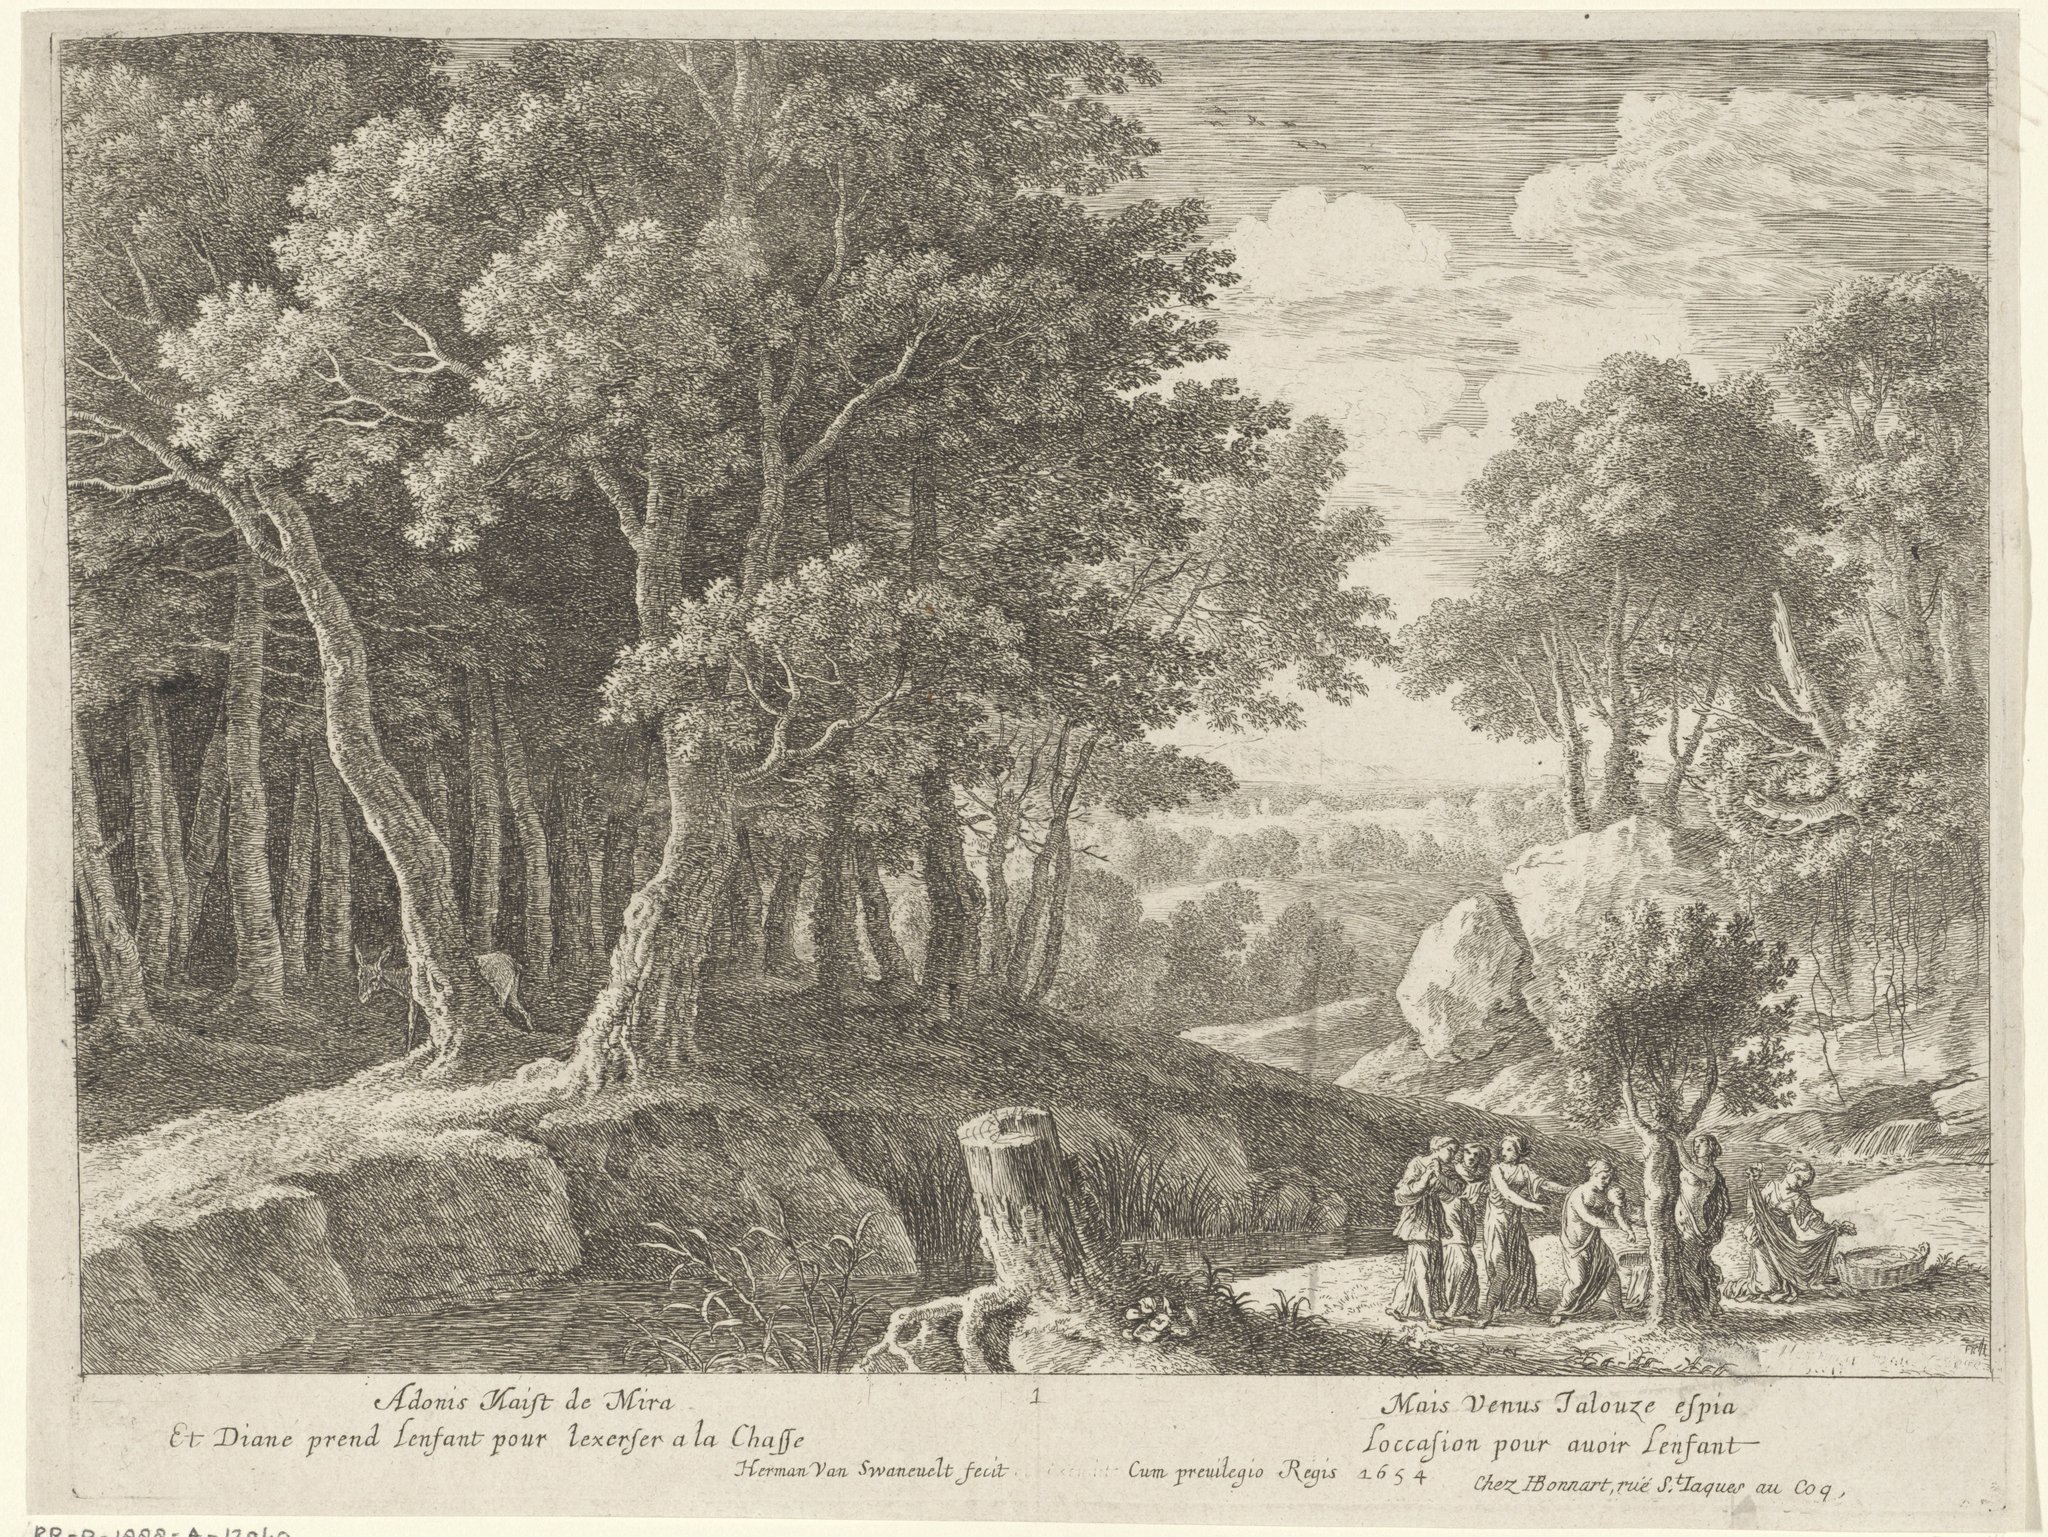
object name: print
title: Geboorte van Adonis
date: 1654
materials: paper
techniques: etching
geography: paris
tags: birth of adonis: the tree splits open to release the baby; the naiads take care of him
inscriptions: collector's mark: Lugt 2228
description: In een heuvelachtig landschap met een rivier staan rechts op de voorgrond vier waternimfen bij Myrrha die bijna helemaal in een mirreboom is veranderd. Diana haalt Adonis uit de boom, terwijl een andere, vijfde waternimf achter de boom een mandje klaarmaakt. Onderaan wordt de episode in het verhaal toegelicht in een vierregelige, Franse tekst.